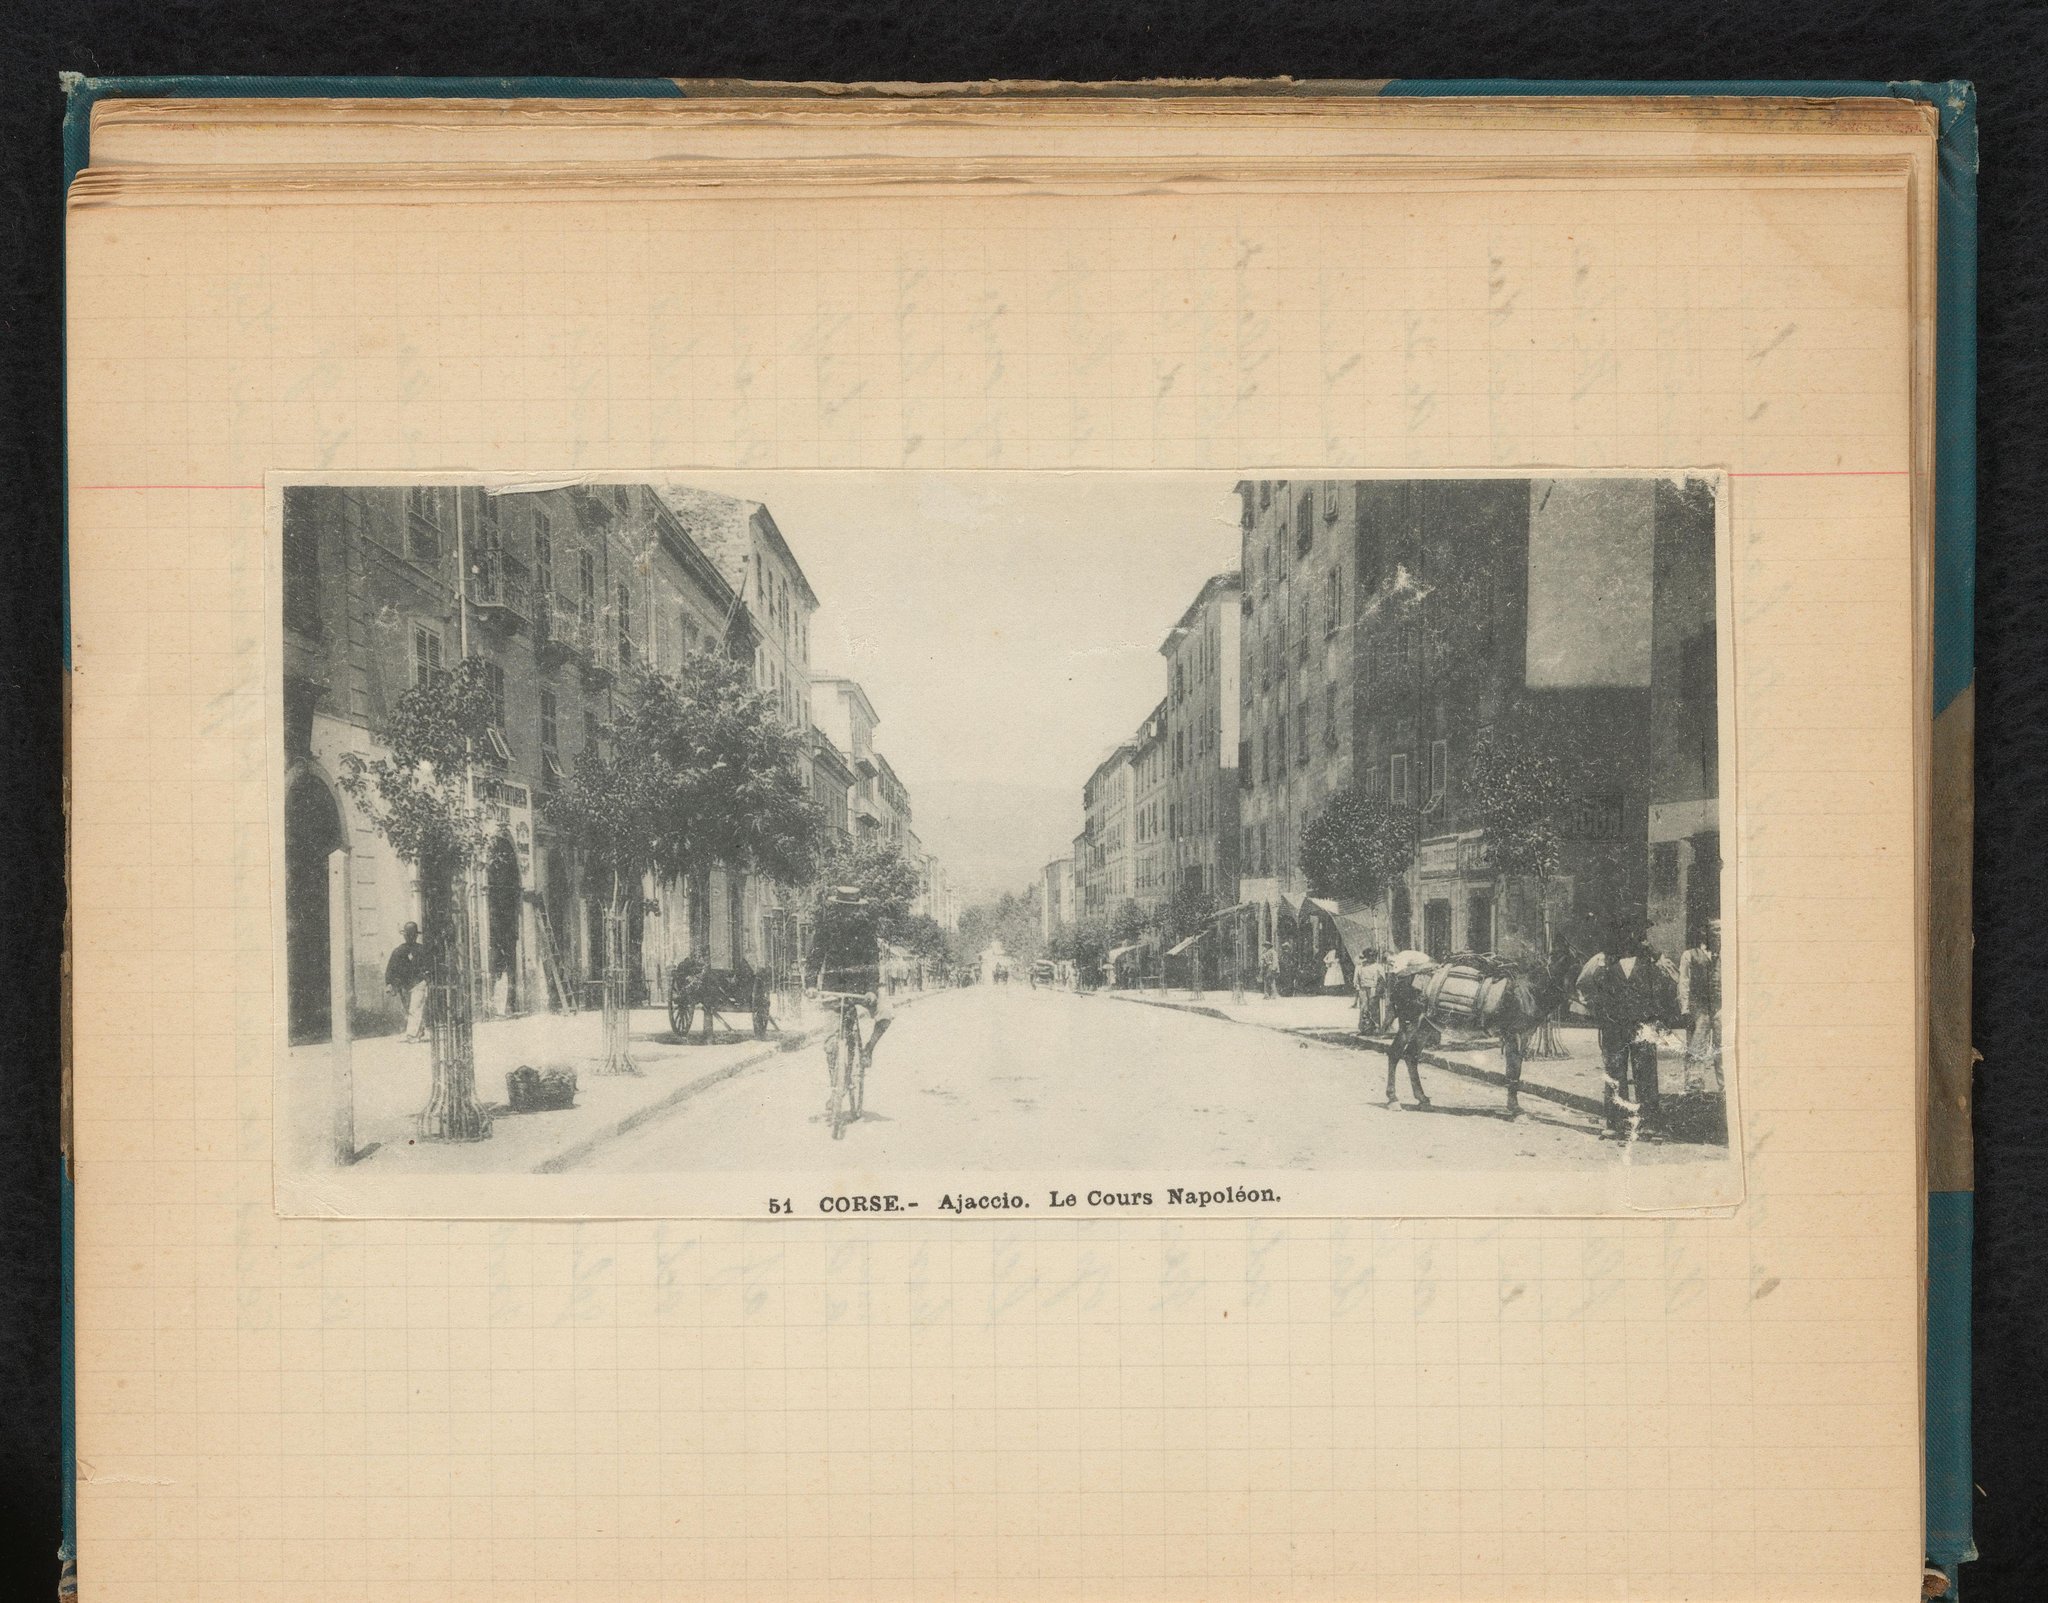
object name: photomechanical print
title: Corsica, Ajaccio, Le Cours Napoléon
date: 1902-1904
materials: paper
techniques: photograph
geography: ajaccio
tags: riding, cycling (recreation), ass, donkey, street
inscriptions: inscription: ‘51 CORSE. - Ajaccio. Le Cours Napoléon.’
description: Deze prent maakt deel uit van een album.